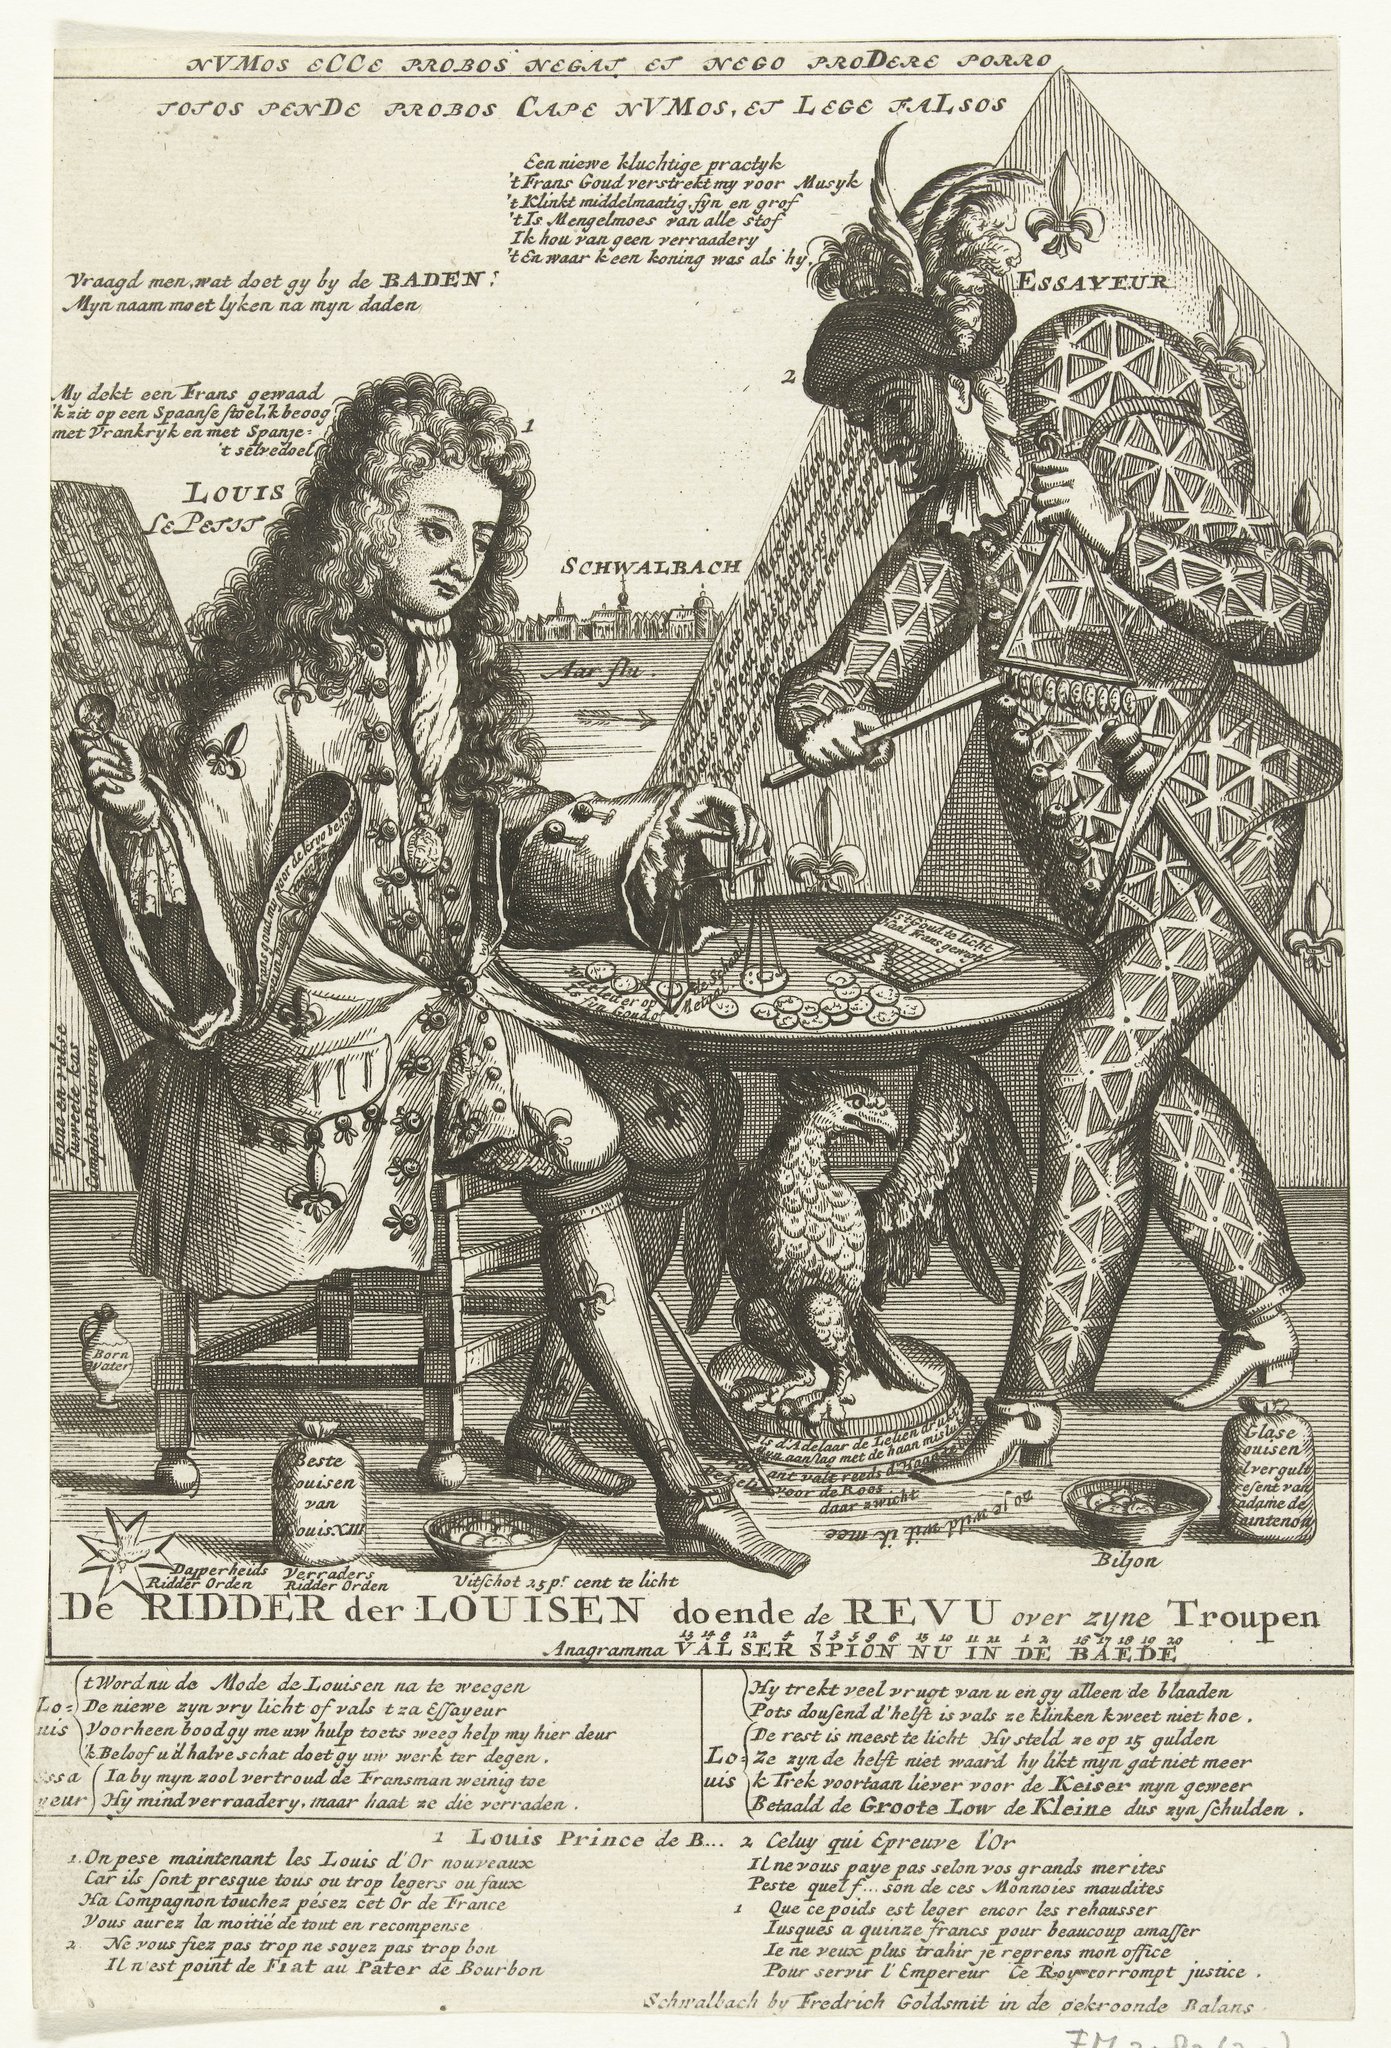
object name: print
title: Harlekijn bij Lodewijk Willem van Baden-Baden, 1705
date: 1705-1706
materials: paper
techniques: etching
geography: amsterdam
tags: lodewijk xiv (koning van frankrijk), paris, weighing gold or money, types in 'commedia dell'arte': harlequin, political caricatures and satires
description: Harlekijn (koning Lodewijk XIV) met triangel en bochel komt Lodewijk Willem, markgraaf van Baden-Baden, die geld aan het wegen is, overreden over te lopen naar Franse zijde. Met verzen in het Nederlands en Frans in de plaat. Onderdeel van een reeks van 7 spotprenten op de Fransen en bondgenoten uit het jaar 1705.